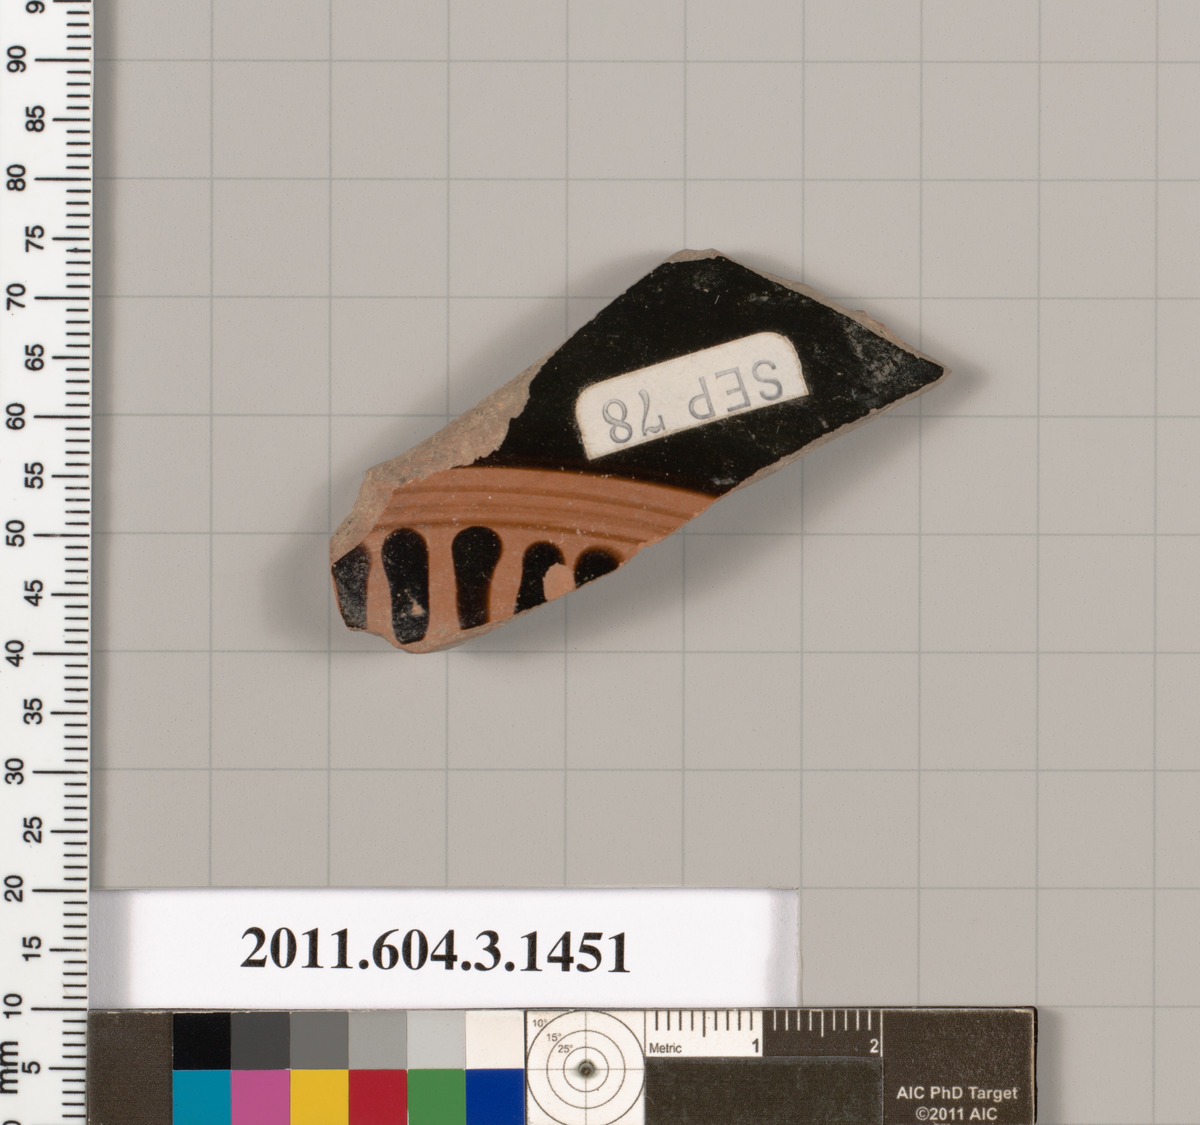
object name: skyphos fragment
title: Terracotta fragment of a skyphos (deep drinking cup)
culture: greek, attic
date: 534-468 BCE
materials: terracotta